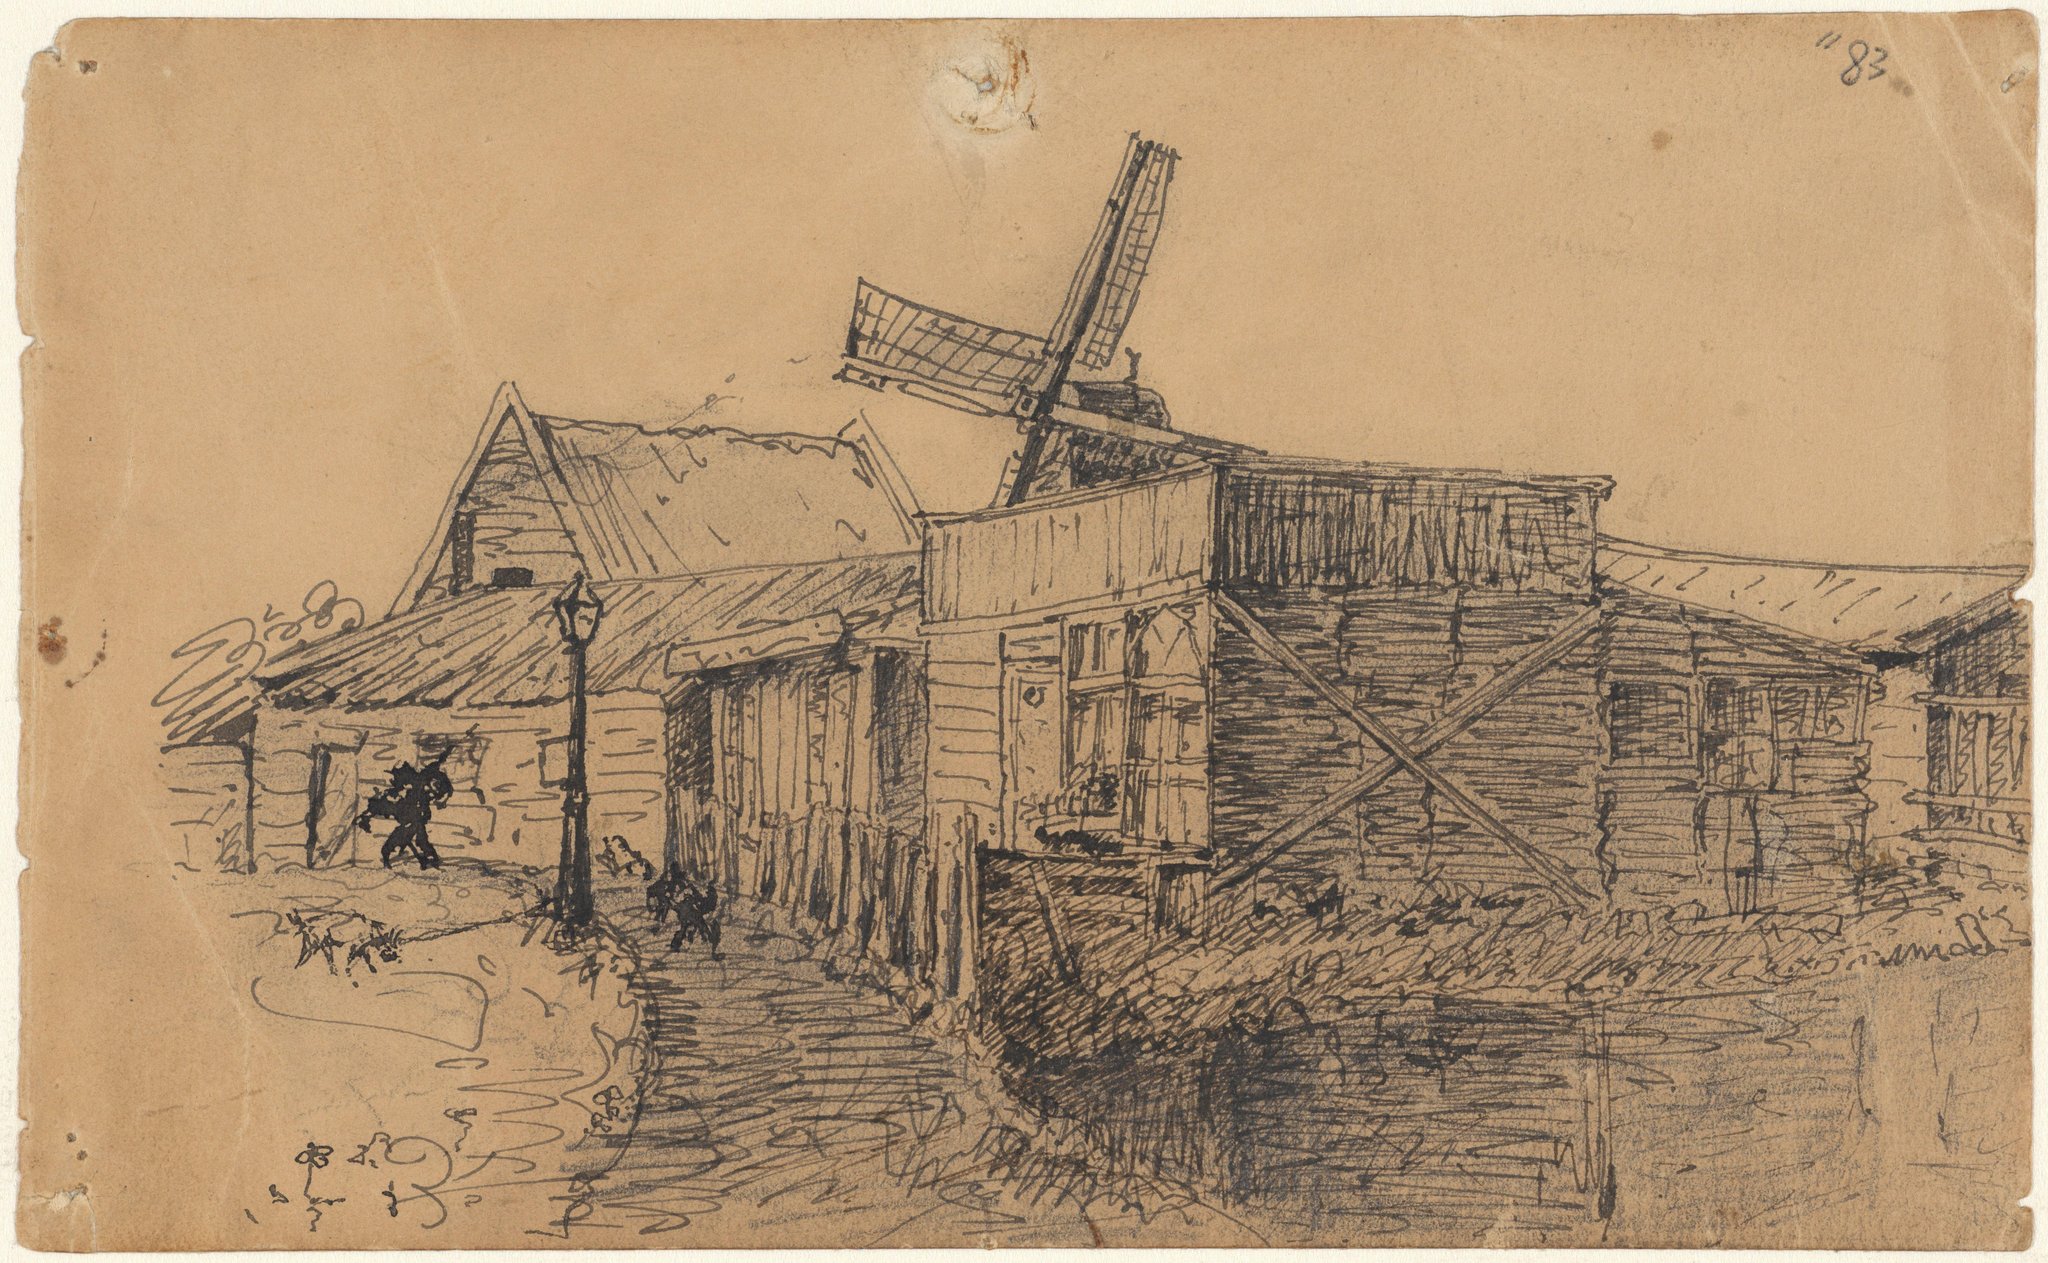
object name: drawing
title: Dorpspad met molen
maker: theo nieuwenhuis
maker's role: designer, draughtsman, print maker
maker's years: 1866-1951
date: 1876-1951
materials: ink, paper, pencil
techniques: pen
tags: village street